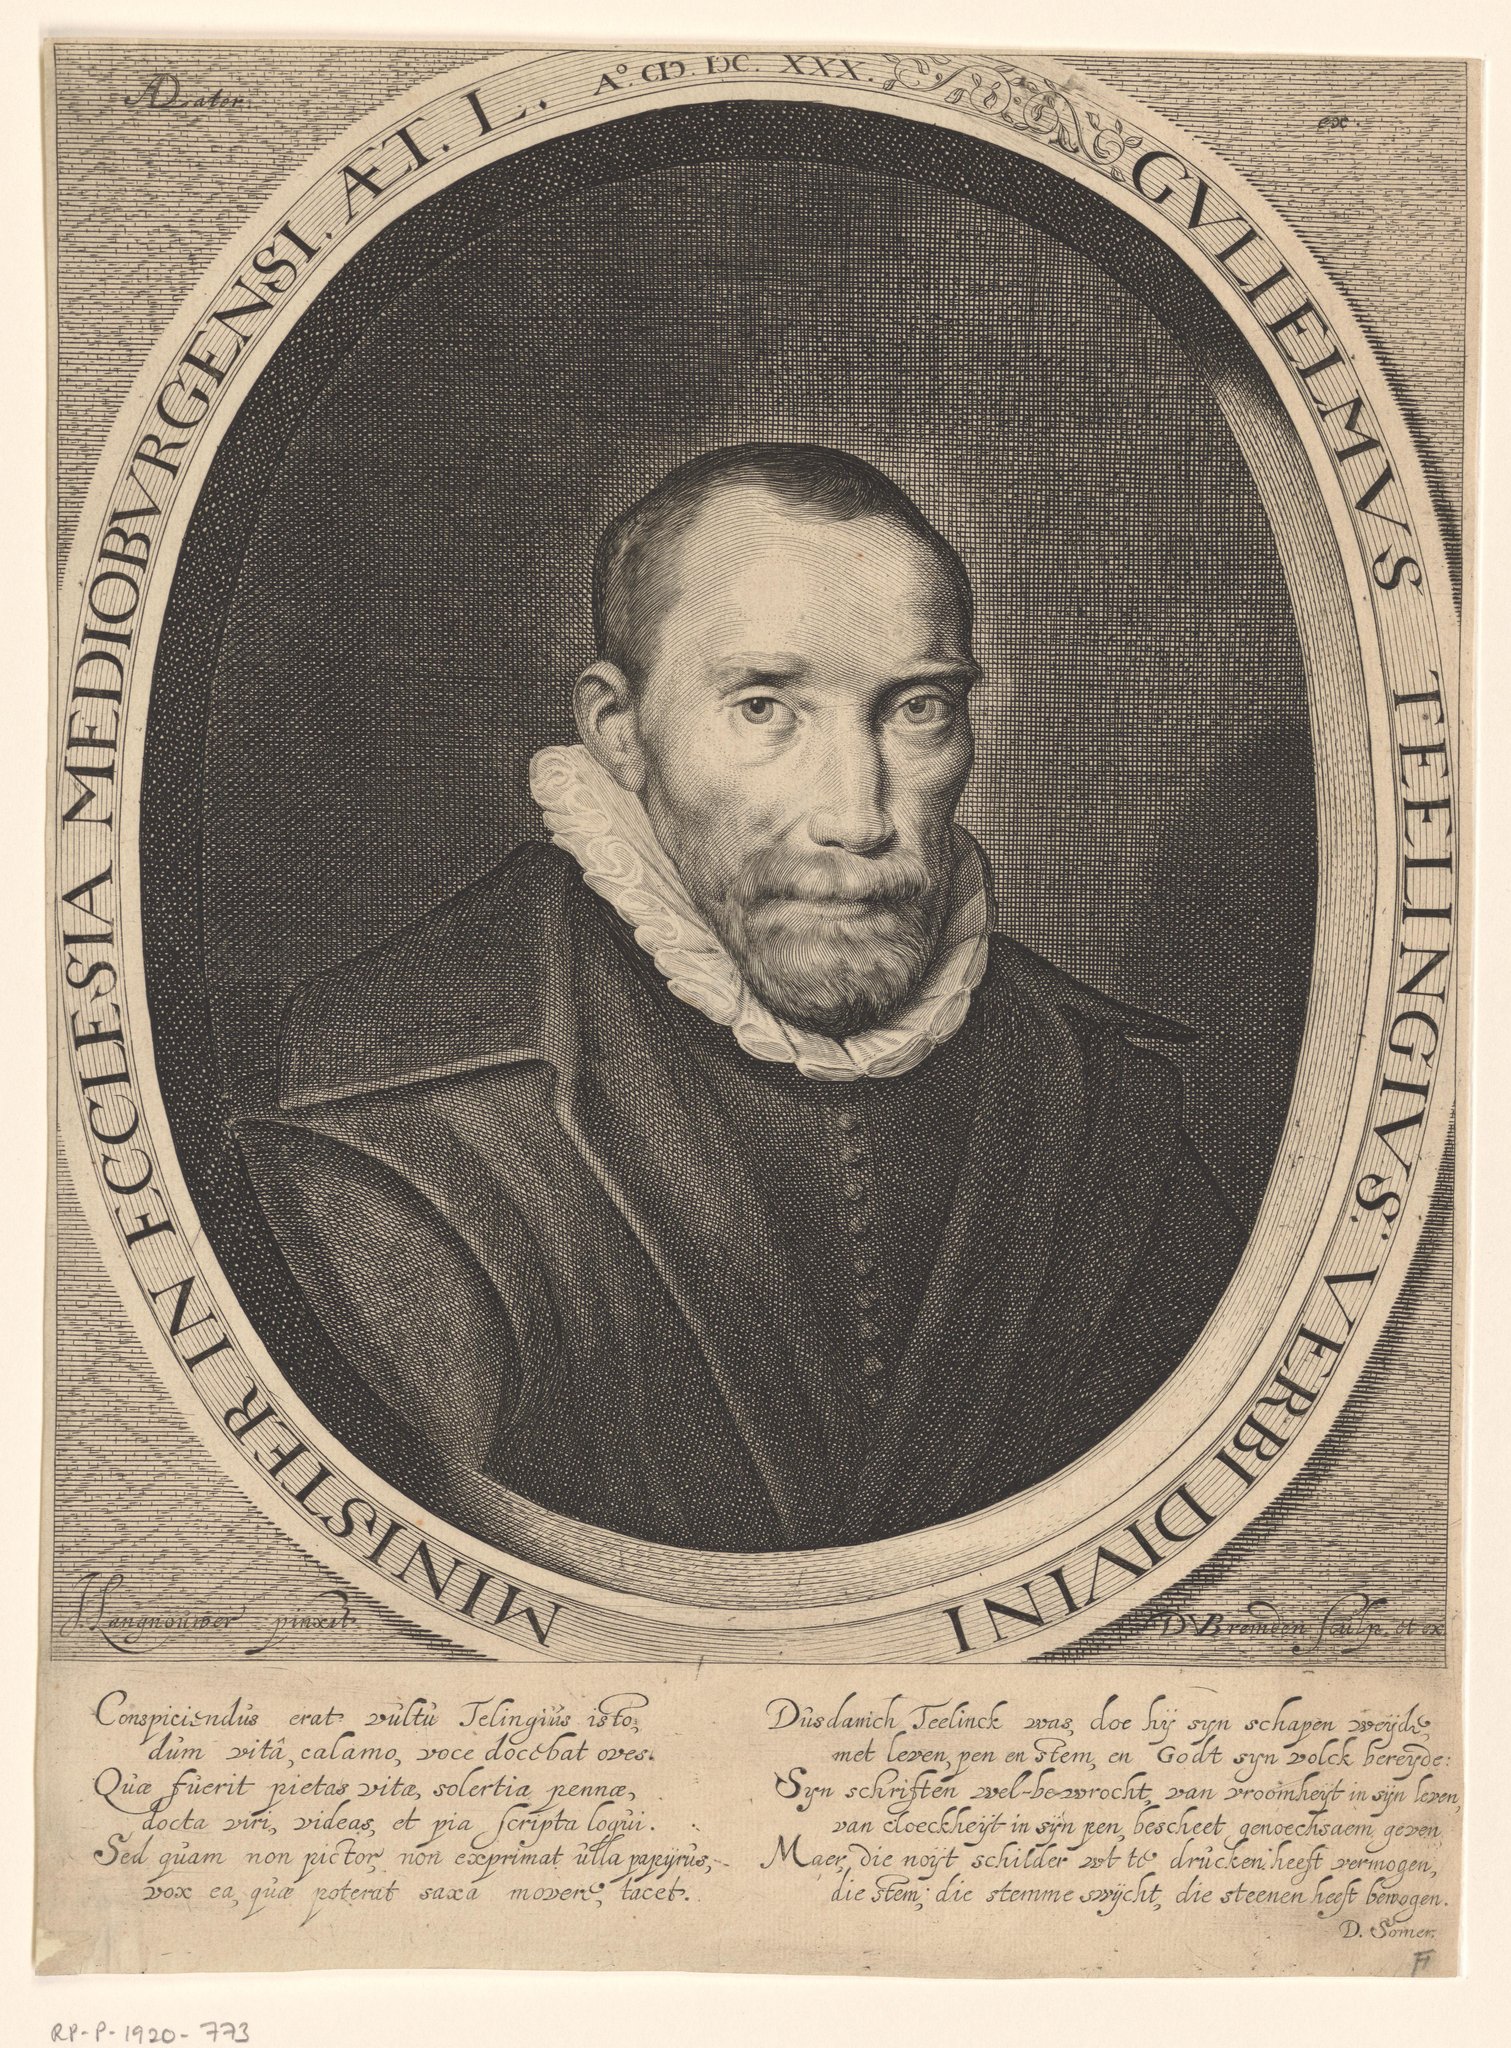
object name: print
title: Portret van Willem Teelinck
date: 1630-1663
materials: paper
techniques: engraving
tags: middelburg, theologian, historical persons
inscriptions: collector's mark: Lugt 2228